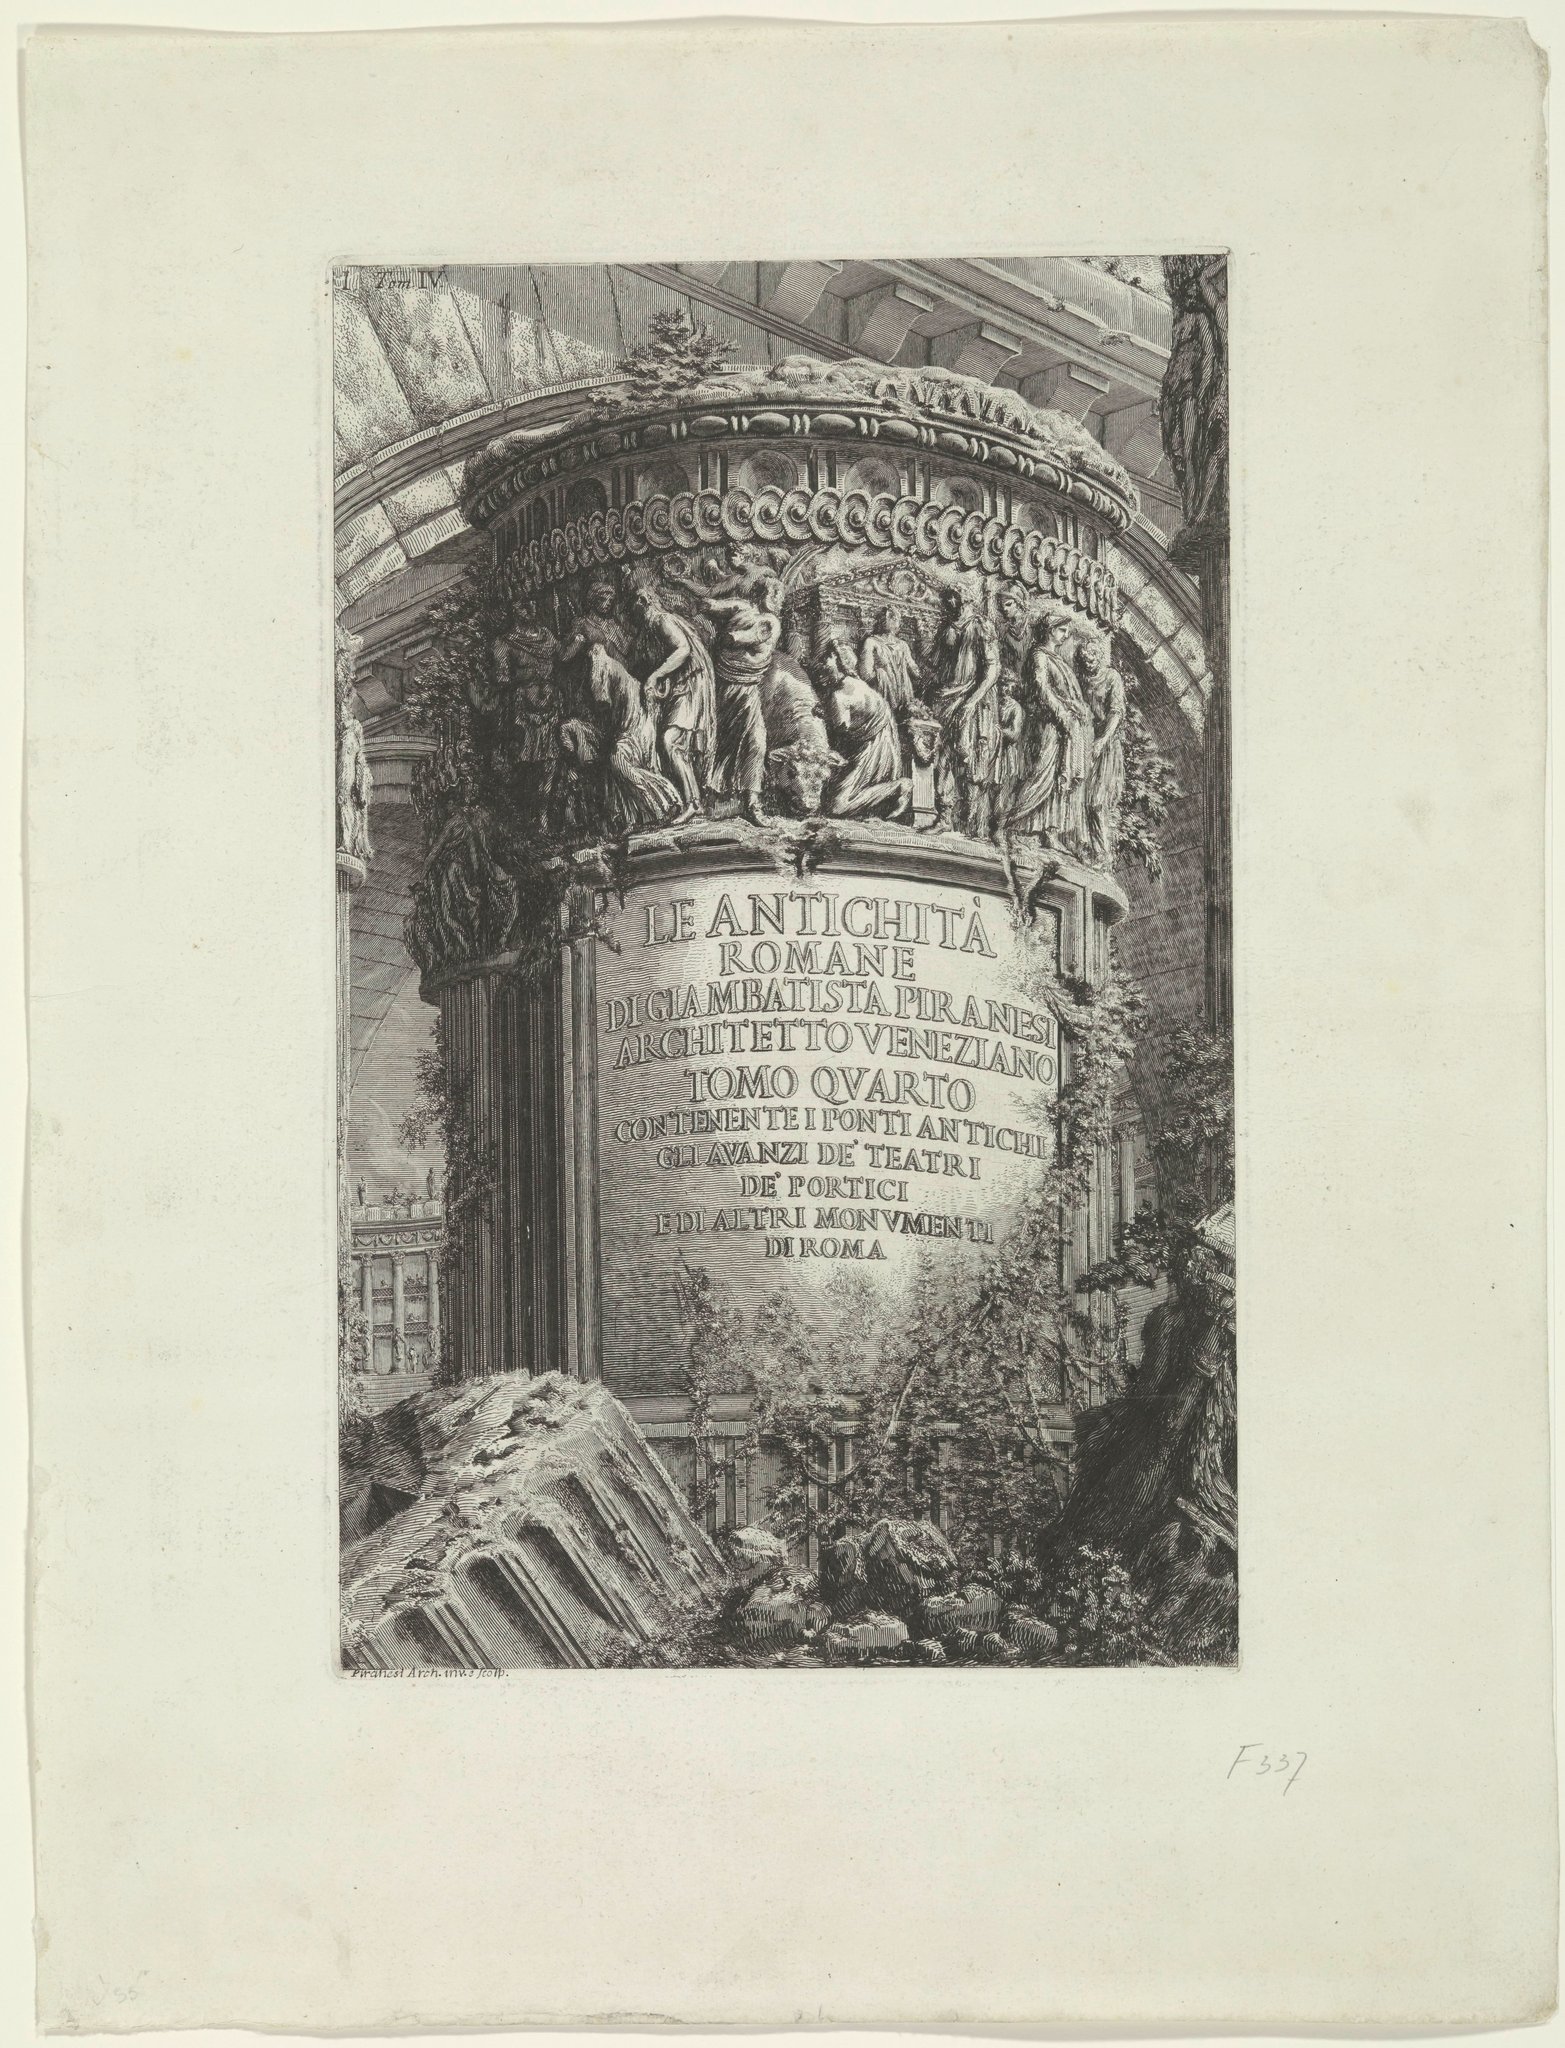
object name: titelprent, frontispice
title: Titelprent met titel op een zuil en bouwfragmenten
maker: giovanni battista piranesi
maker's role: designer, draughtsman, print maker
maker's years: 1720-1778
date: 1756-1757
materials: paper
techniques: etching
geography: rome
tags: column, pillar ~ architecture, ruin of a building ~ architecture, italy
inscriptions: collector's mark: Lugt 2228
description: Titelprent van het vierde deel van de serie 'Le Antichità Romane'. Piranesi deed meer dan acht jaar voorstudie voor deze 250 platen tellende serie die in vier volumes werd uitgegeven. Hij produceerde de prenten tussen ca. 1756 en 1757. De serie bevat ook prenten door of naar andere prentmakers, onder wie Francesco Bianchini en Girolamo Rossi.